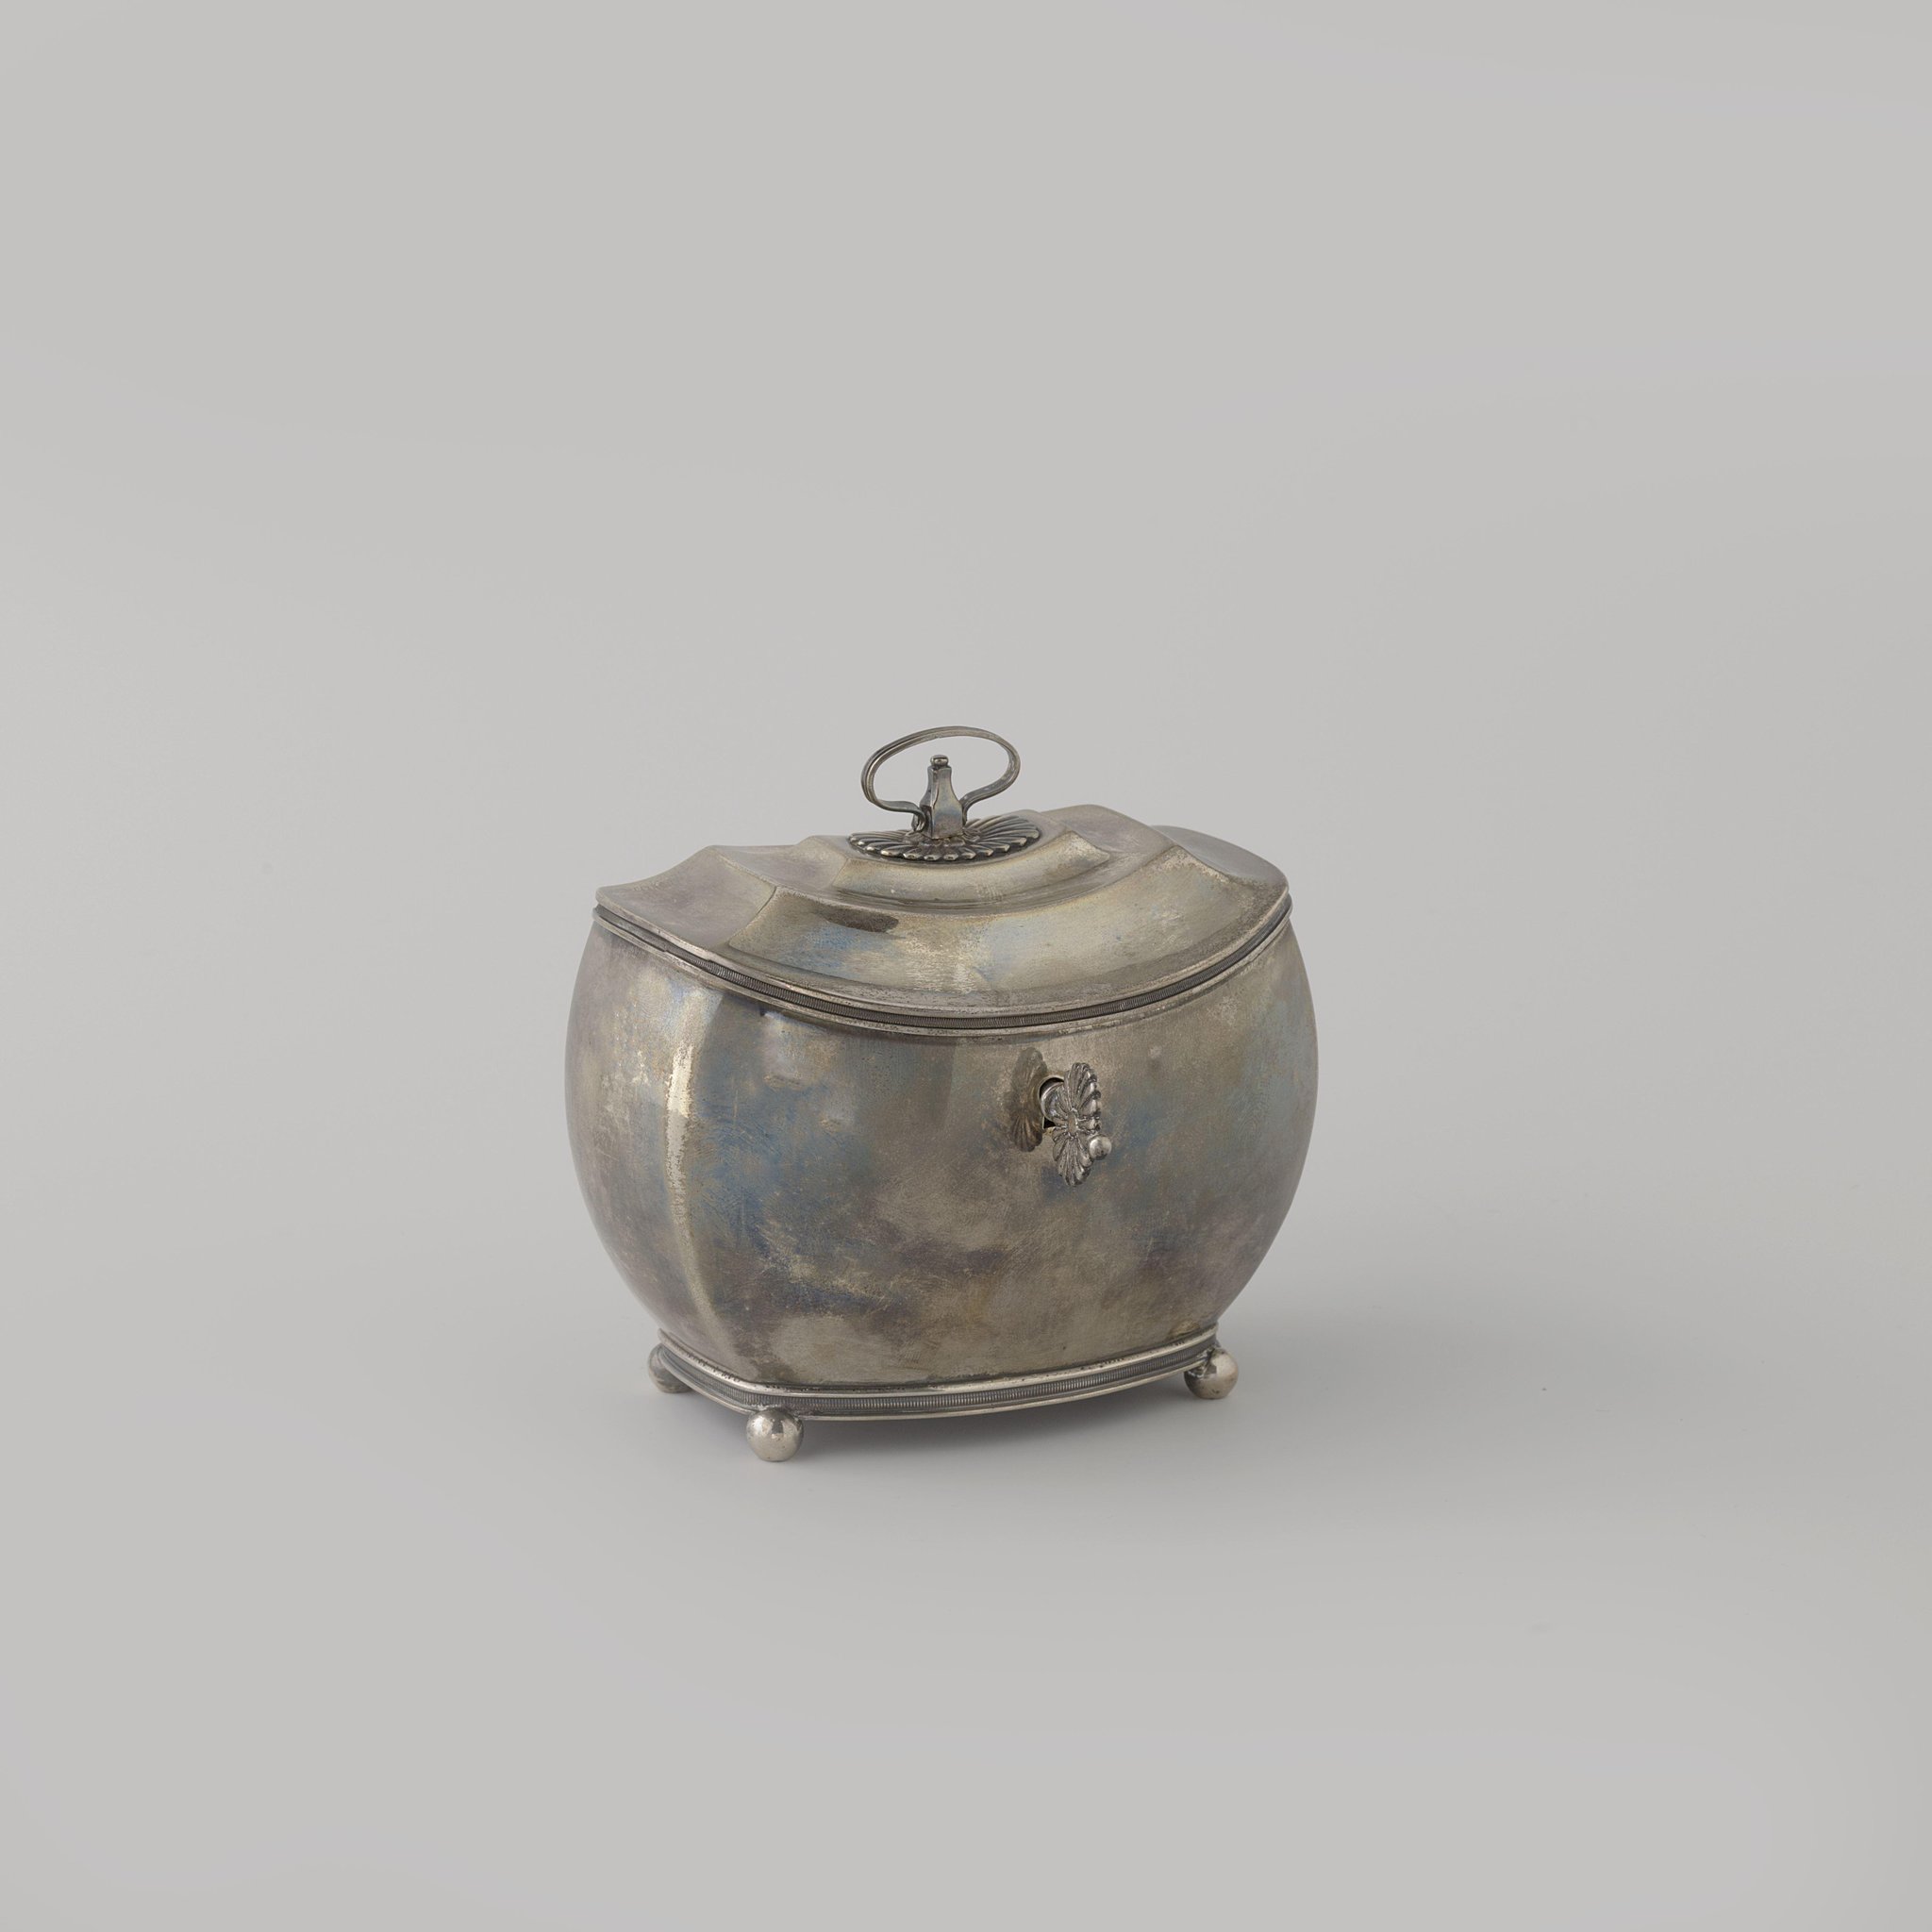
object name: tea caddy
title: Theebus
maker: johannes adrianus van der toorn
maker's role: silversmith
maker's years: 1775-1849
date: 1826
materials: silver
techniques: casting, metalworking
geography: the hague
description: Rechthoekige theebus met openklapbaar deksel. Gemerkt en gedateerd.